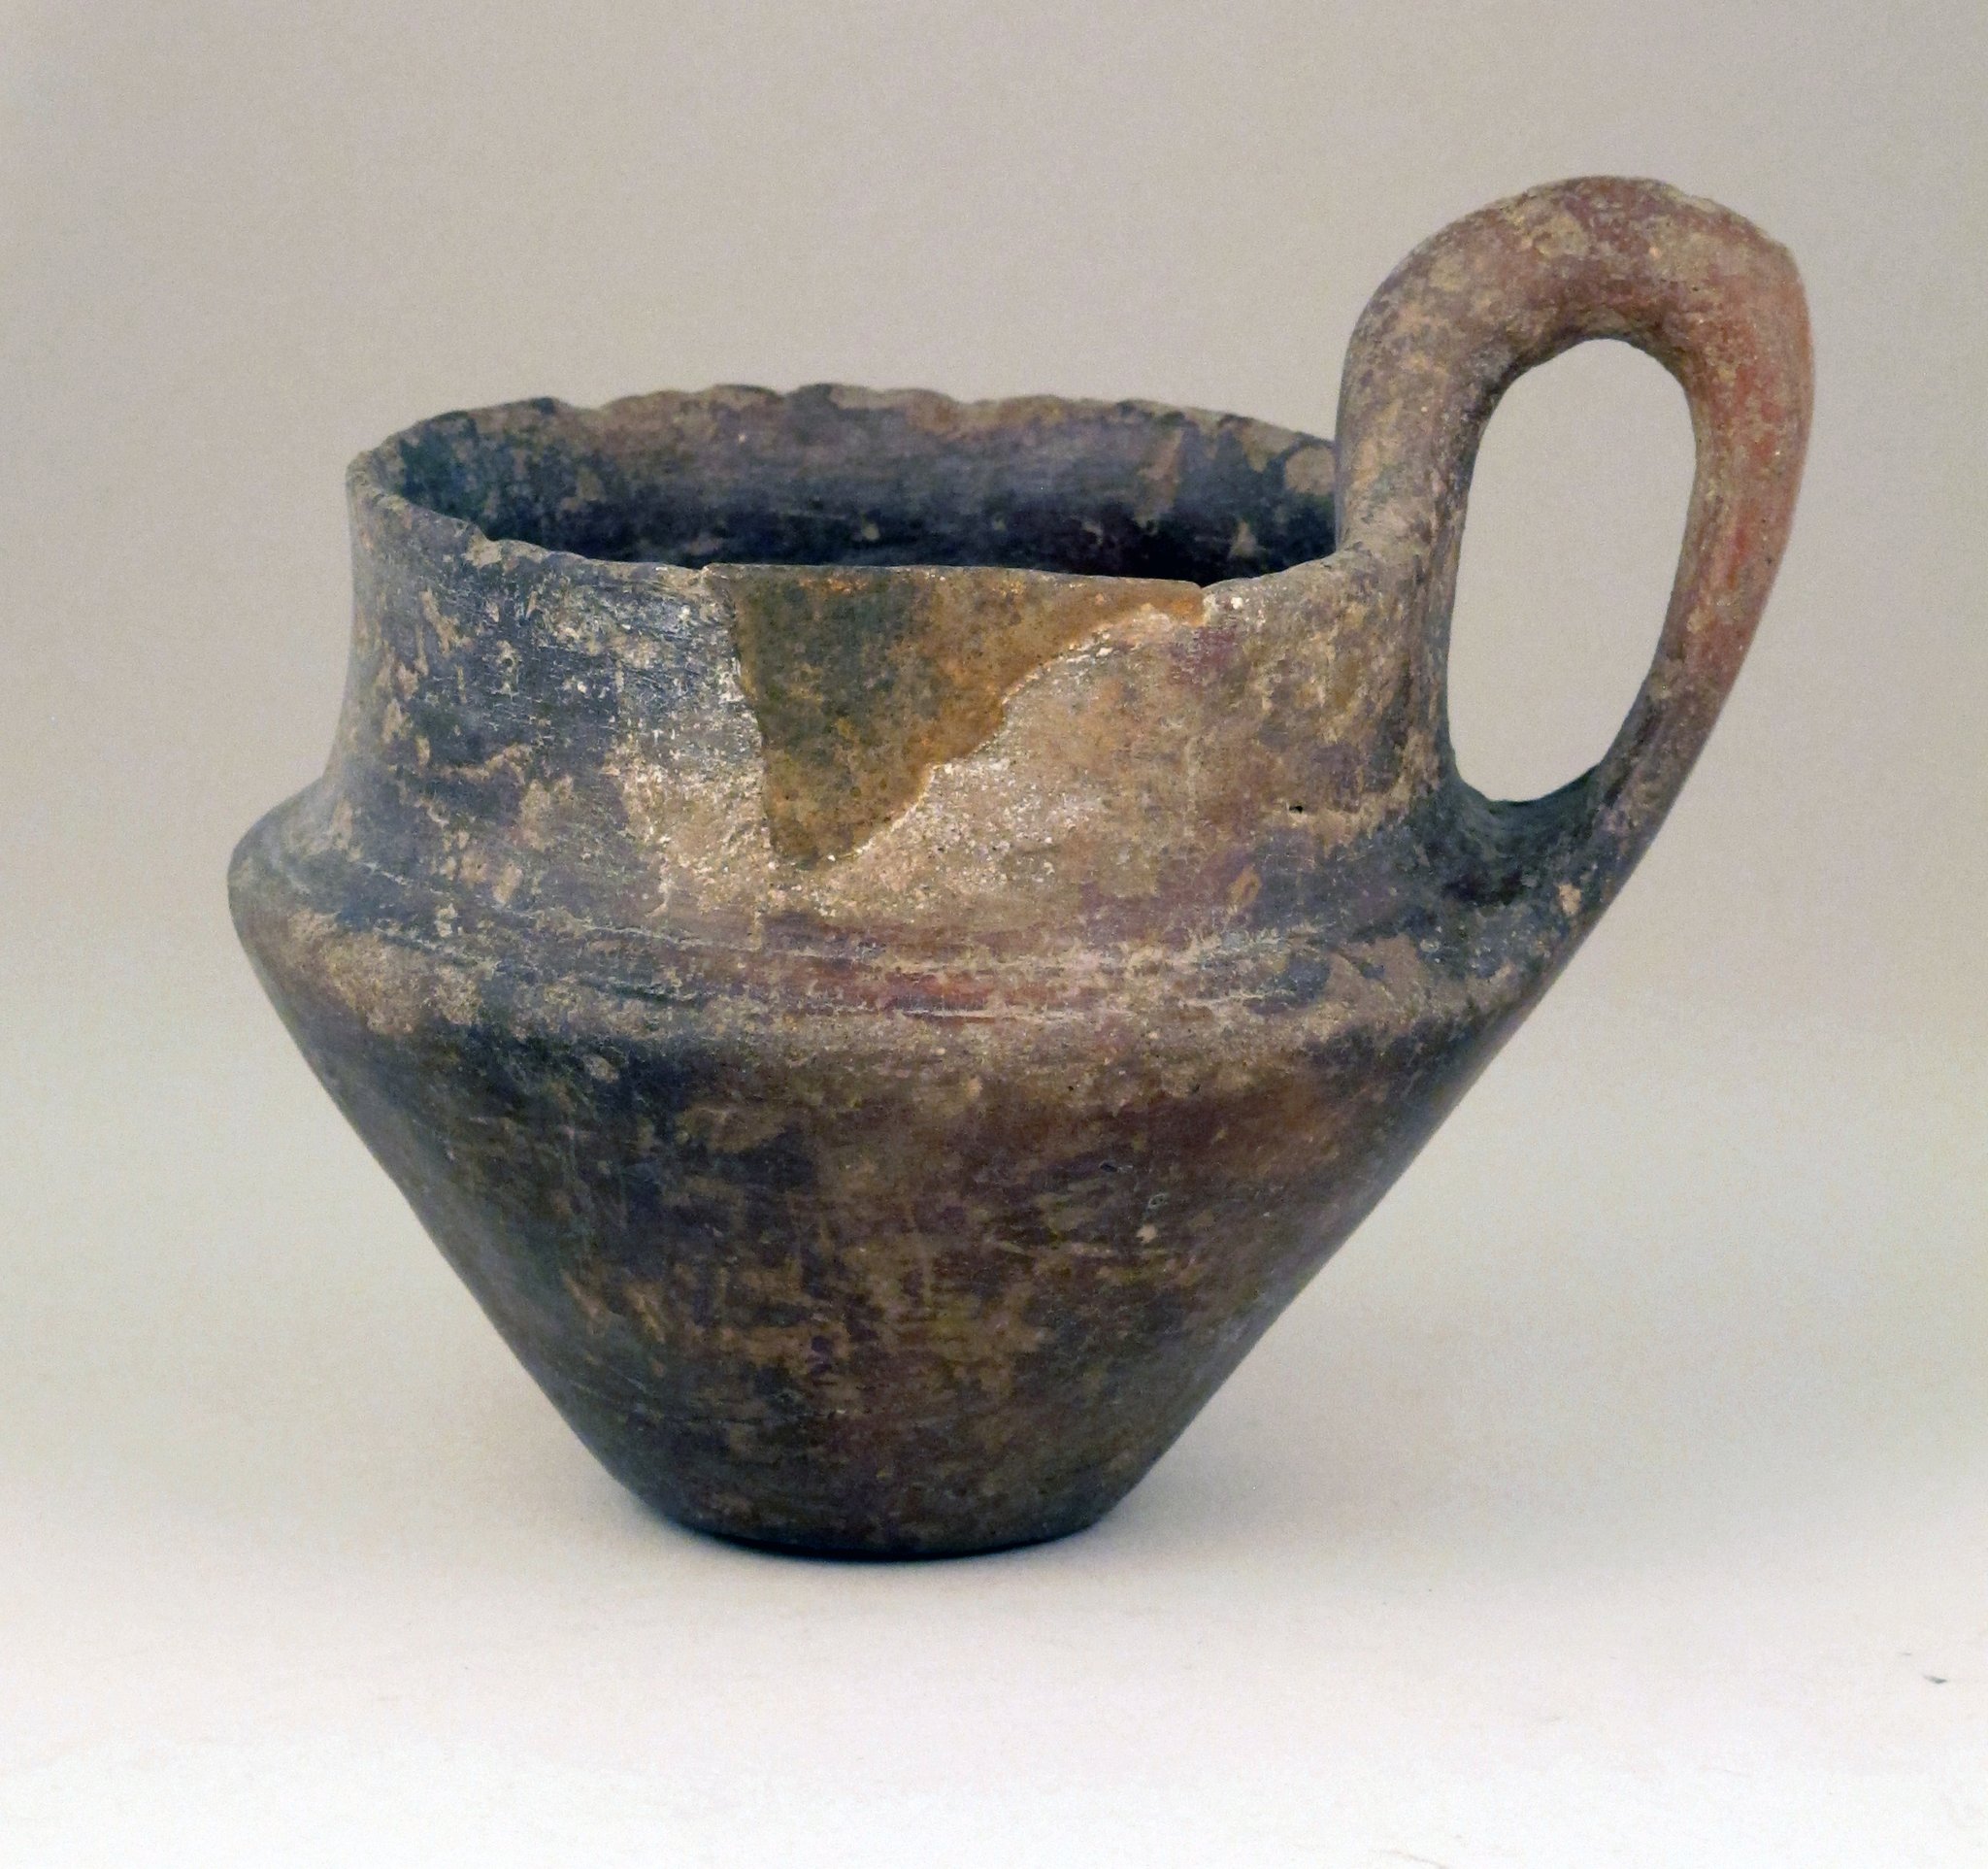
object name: cup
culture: italic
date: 900-100 BCE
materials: terracotta